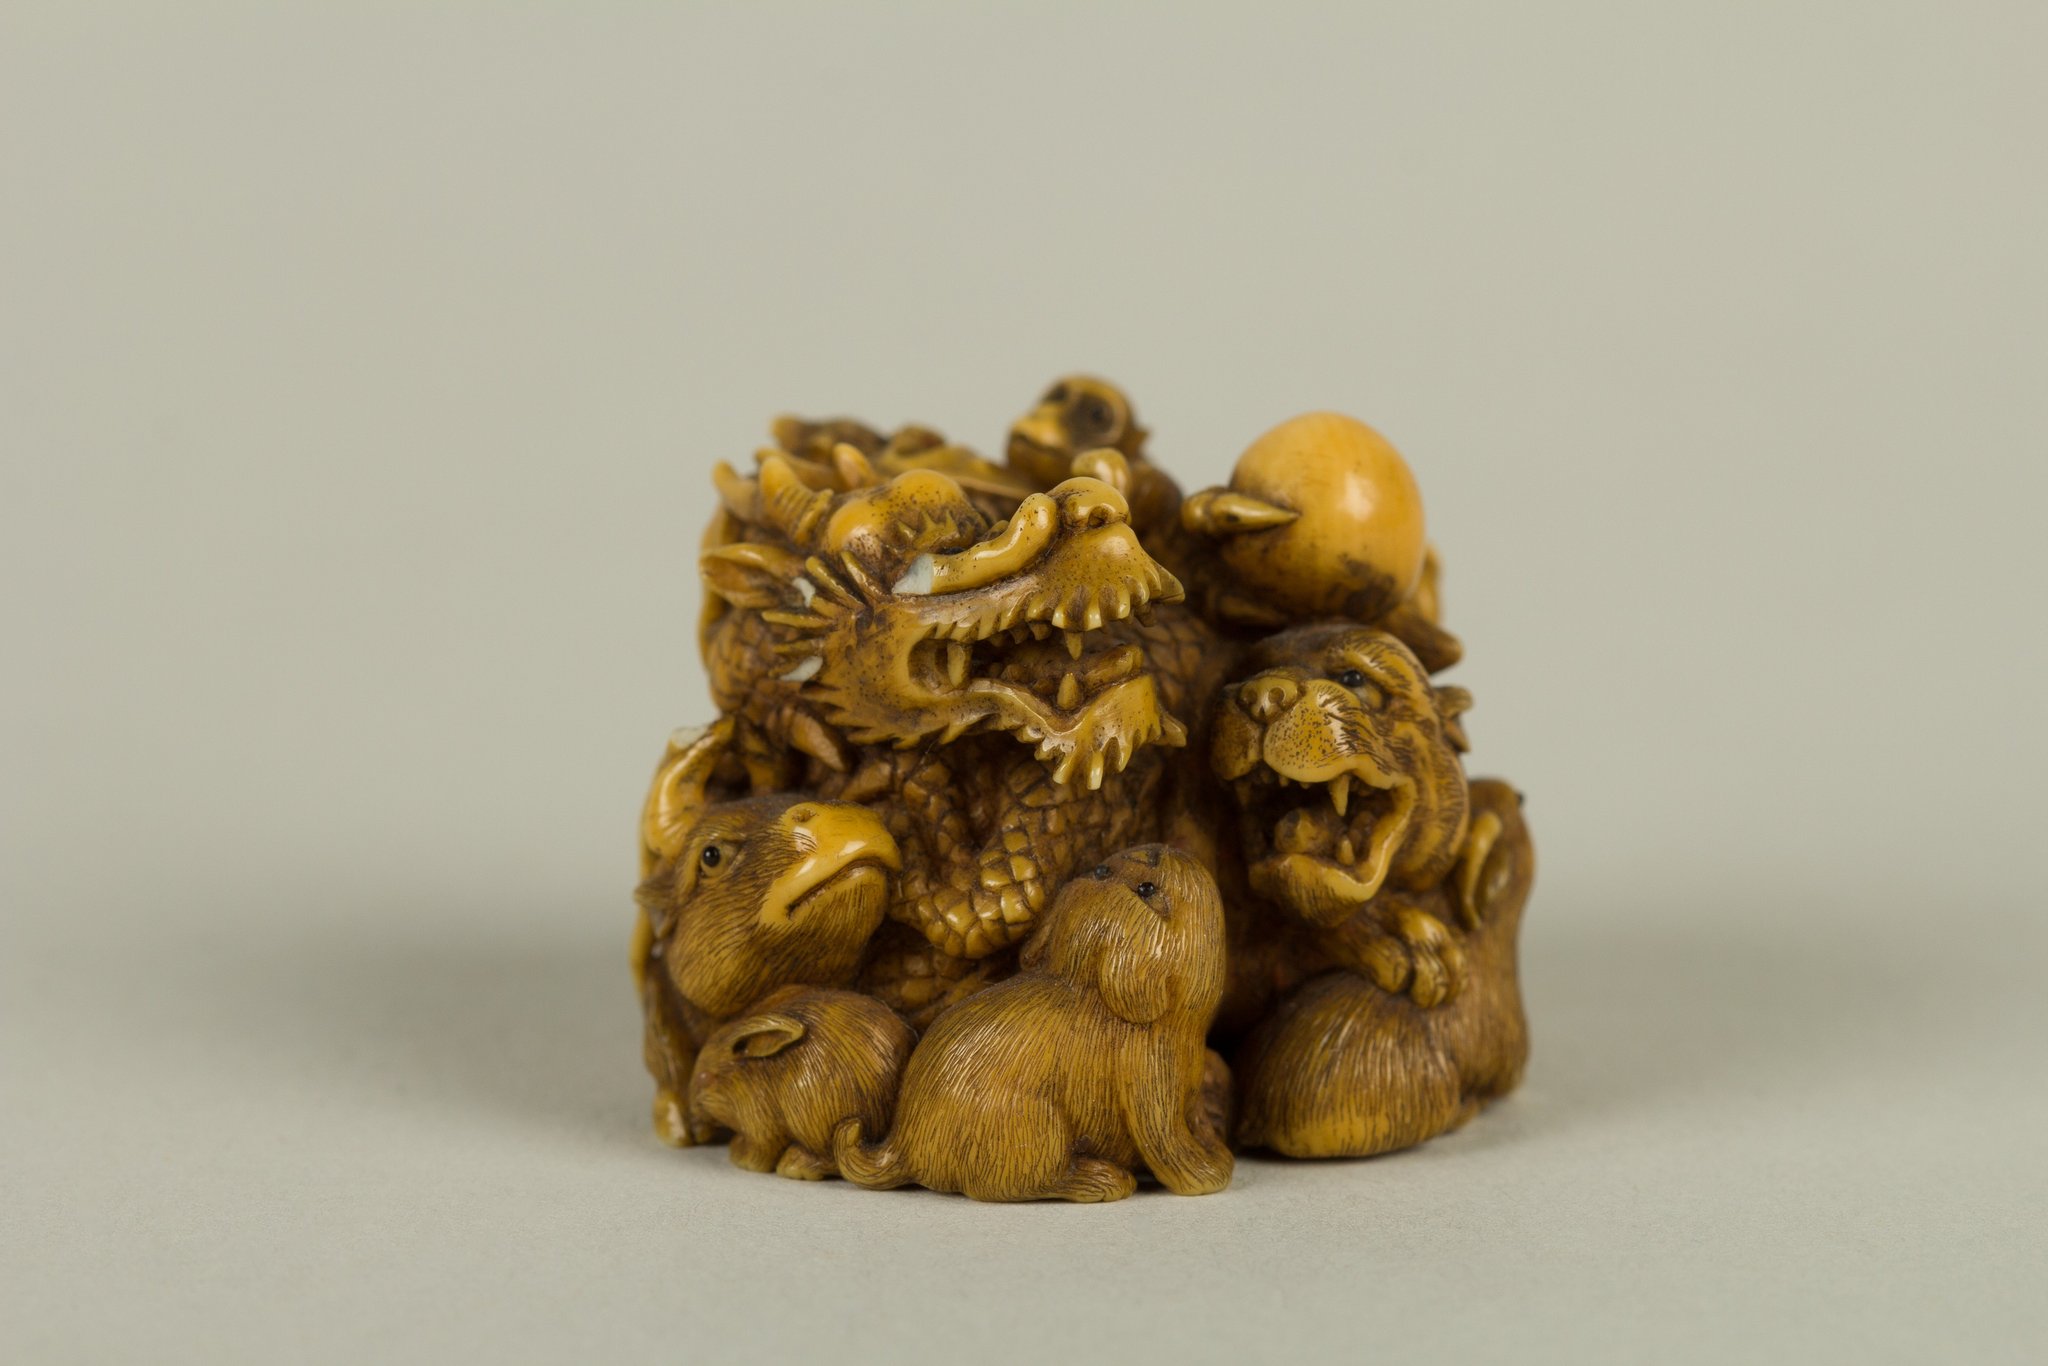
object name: netsuke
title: Netsuke of Group of Animals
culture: japanese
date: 1801-1900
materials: ivory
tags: dragons,boars,cows,horses,mice,monkeys,rabbits